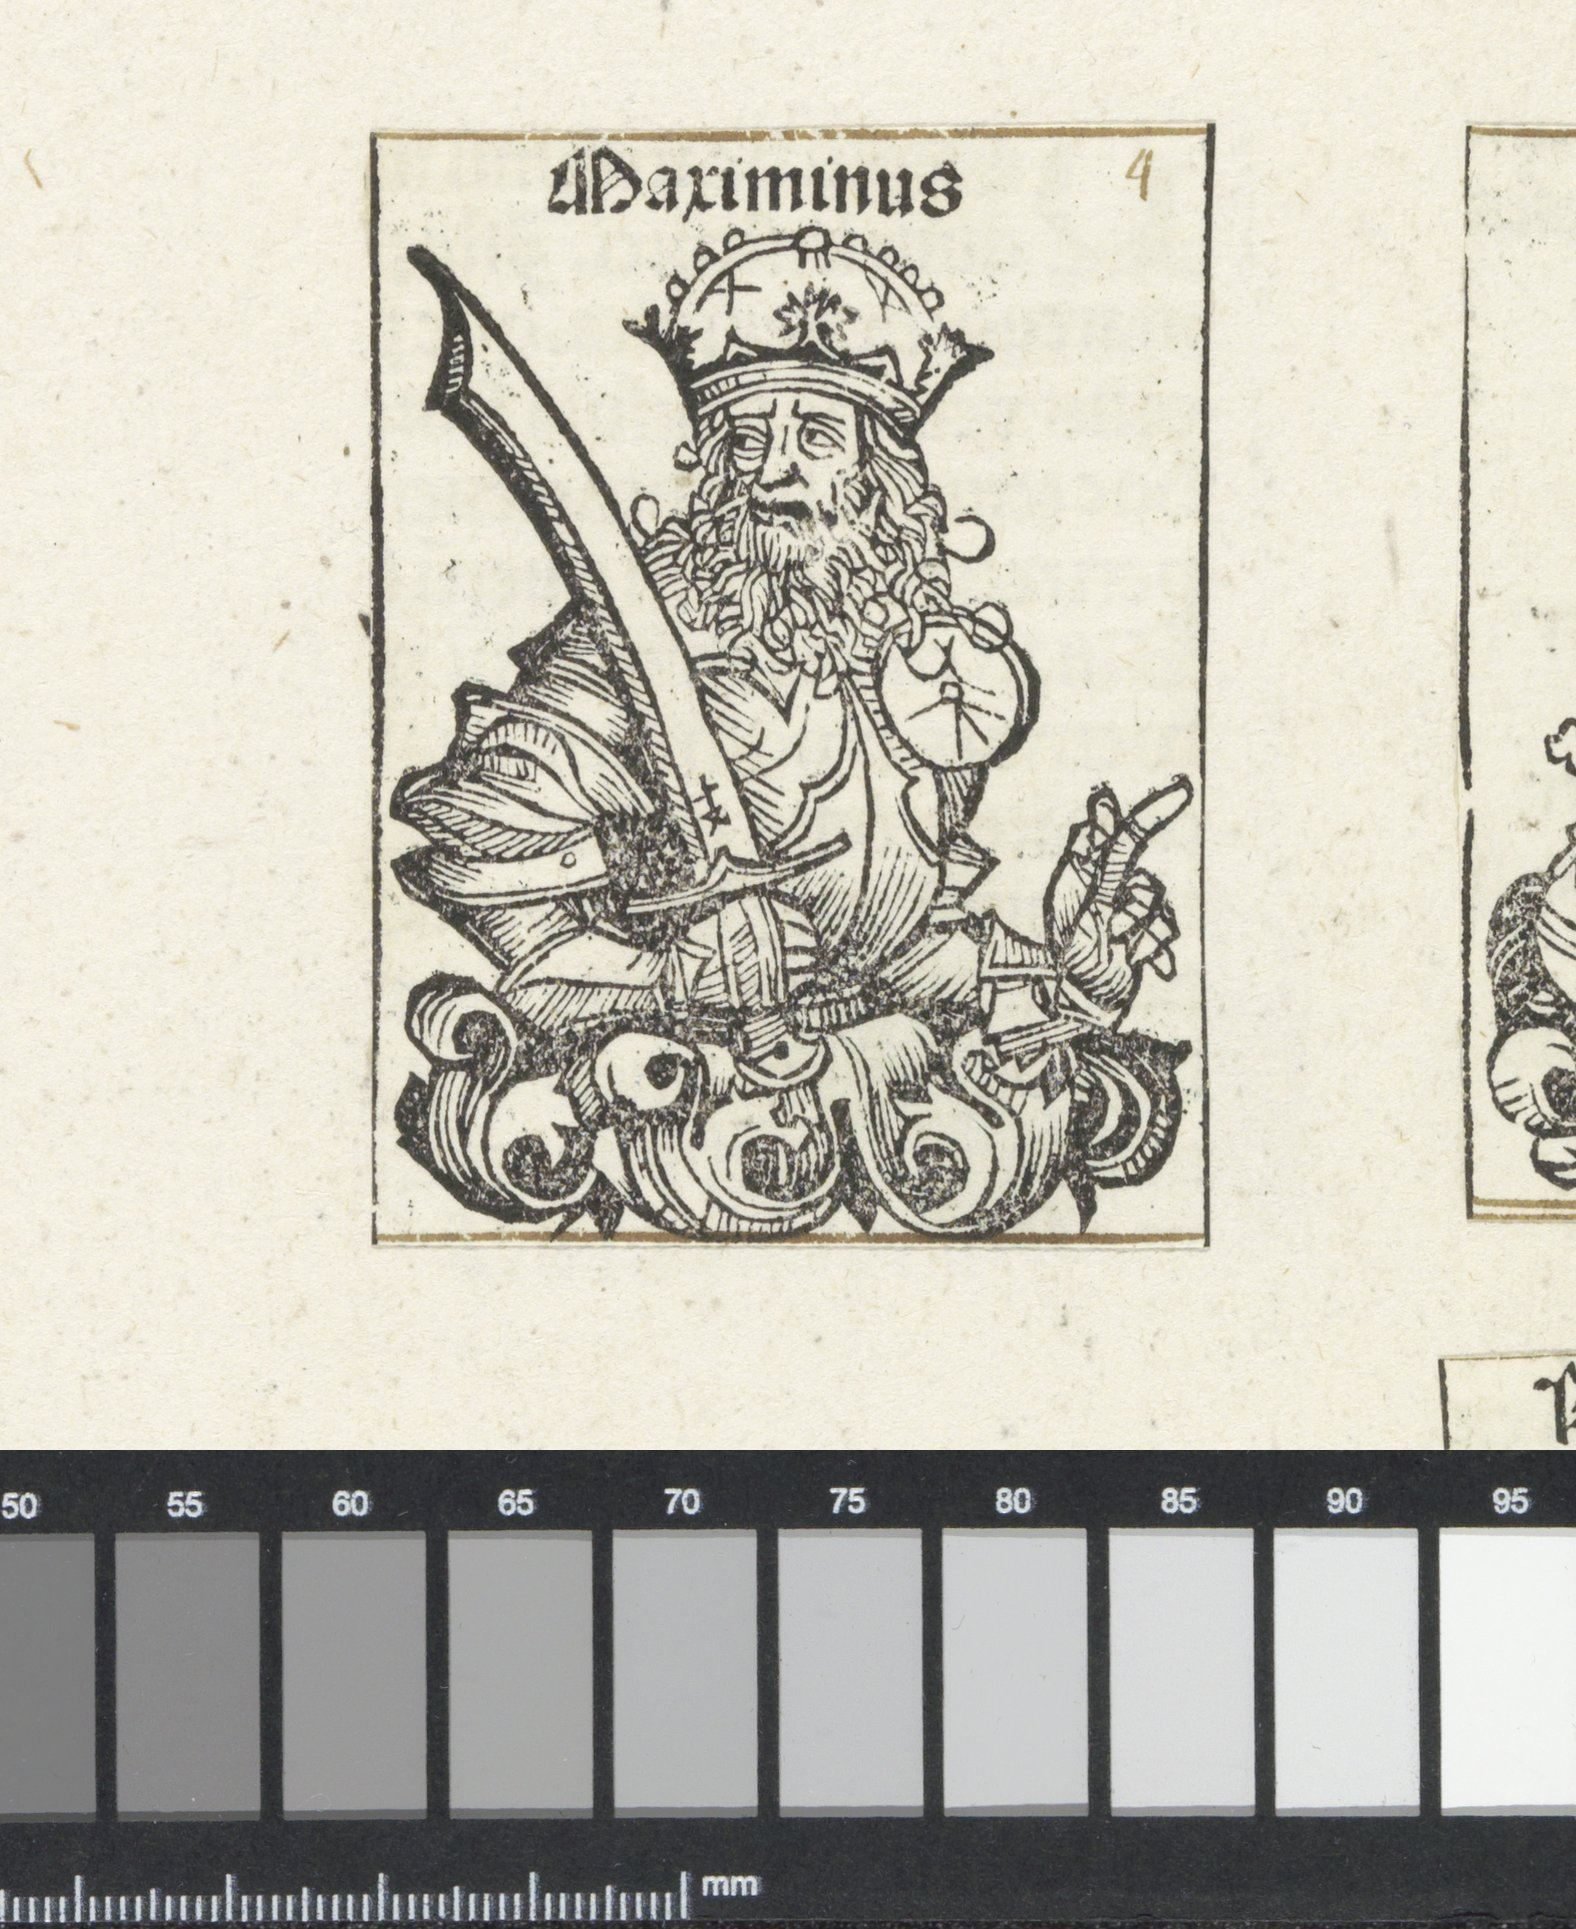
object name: album leaf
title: Keizer Maximinus I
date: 1493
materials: paper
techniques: letterpress printing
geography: nuremberg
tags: emperor, king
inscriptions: inscription: ‘4’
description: Een bloemkelk met een koning, zijn hoofd naar links gedraaid. In zijn handen heeft hij een zwaard. De voorstelling is onderdeel van de opeenvolging Romeinse keizers in de Liber Chronicarum. De tekst identificeert de man als keizer Maximinus I. De prent maakt deel uit van een album.